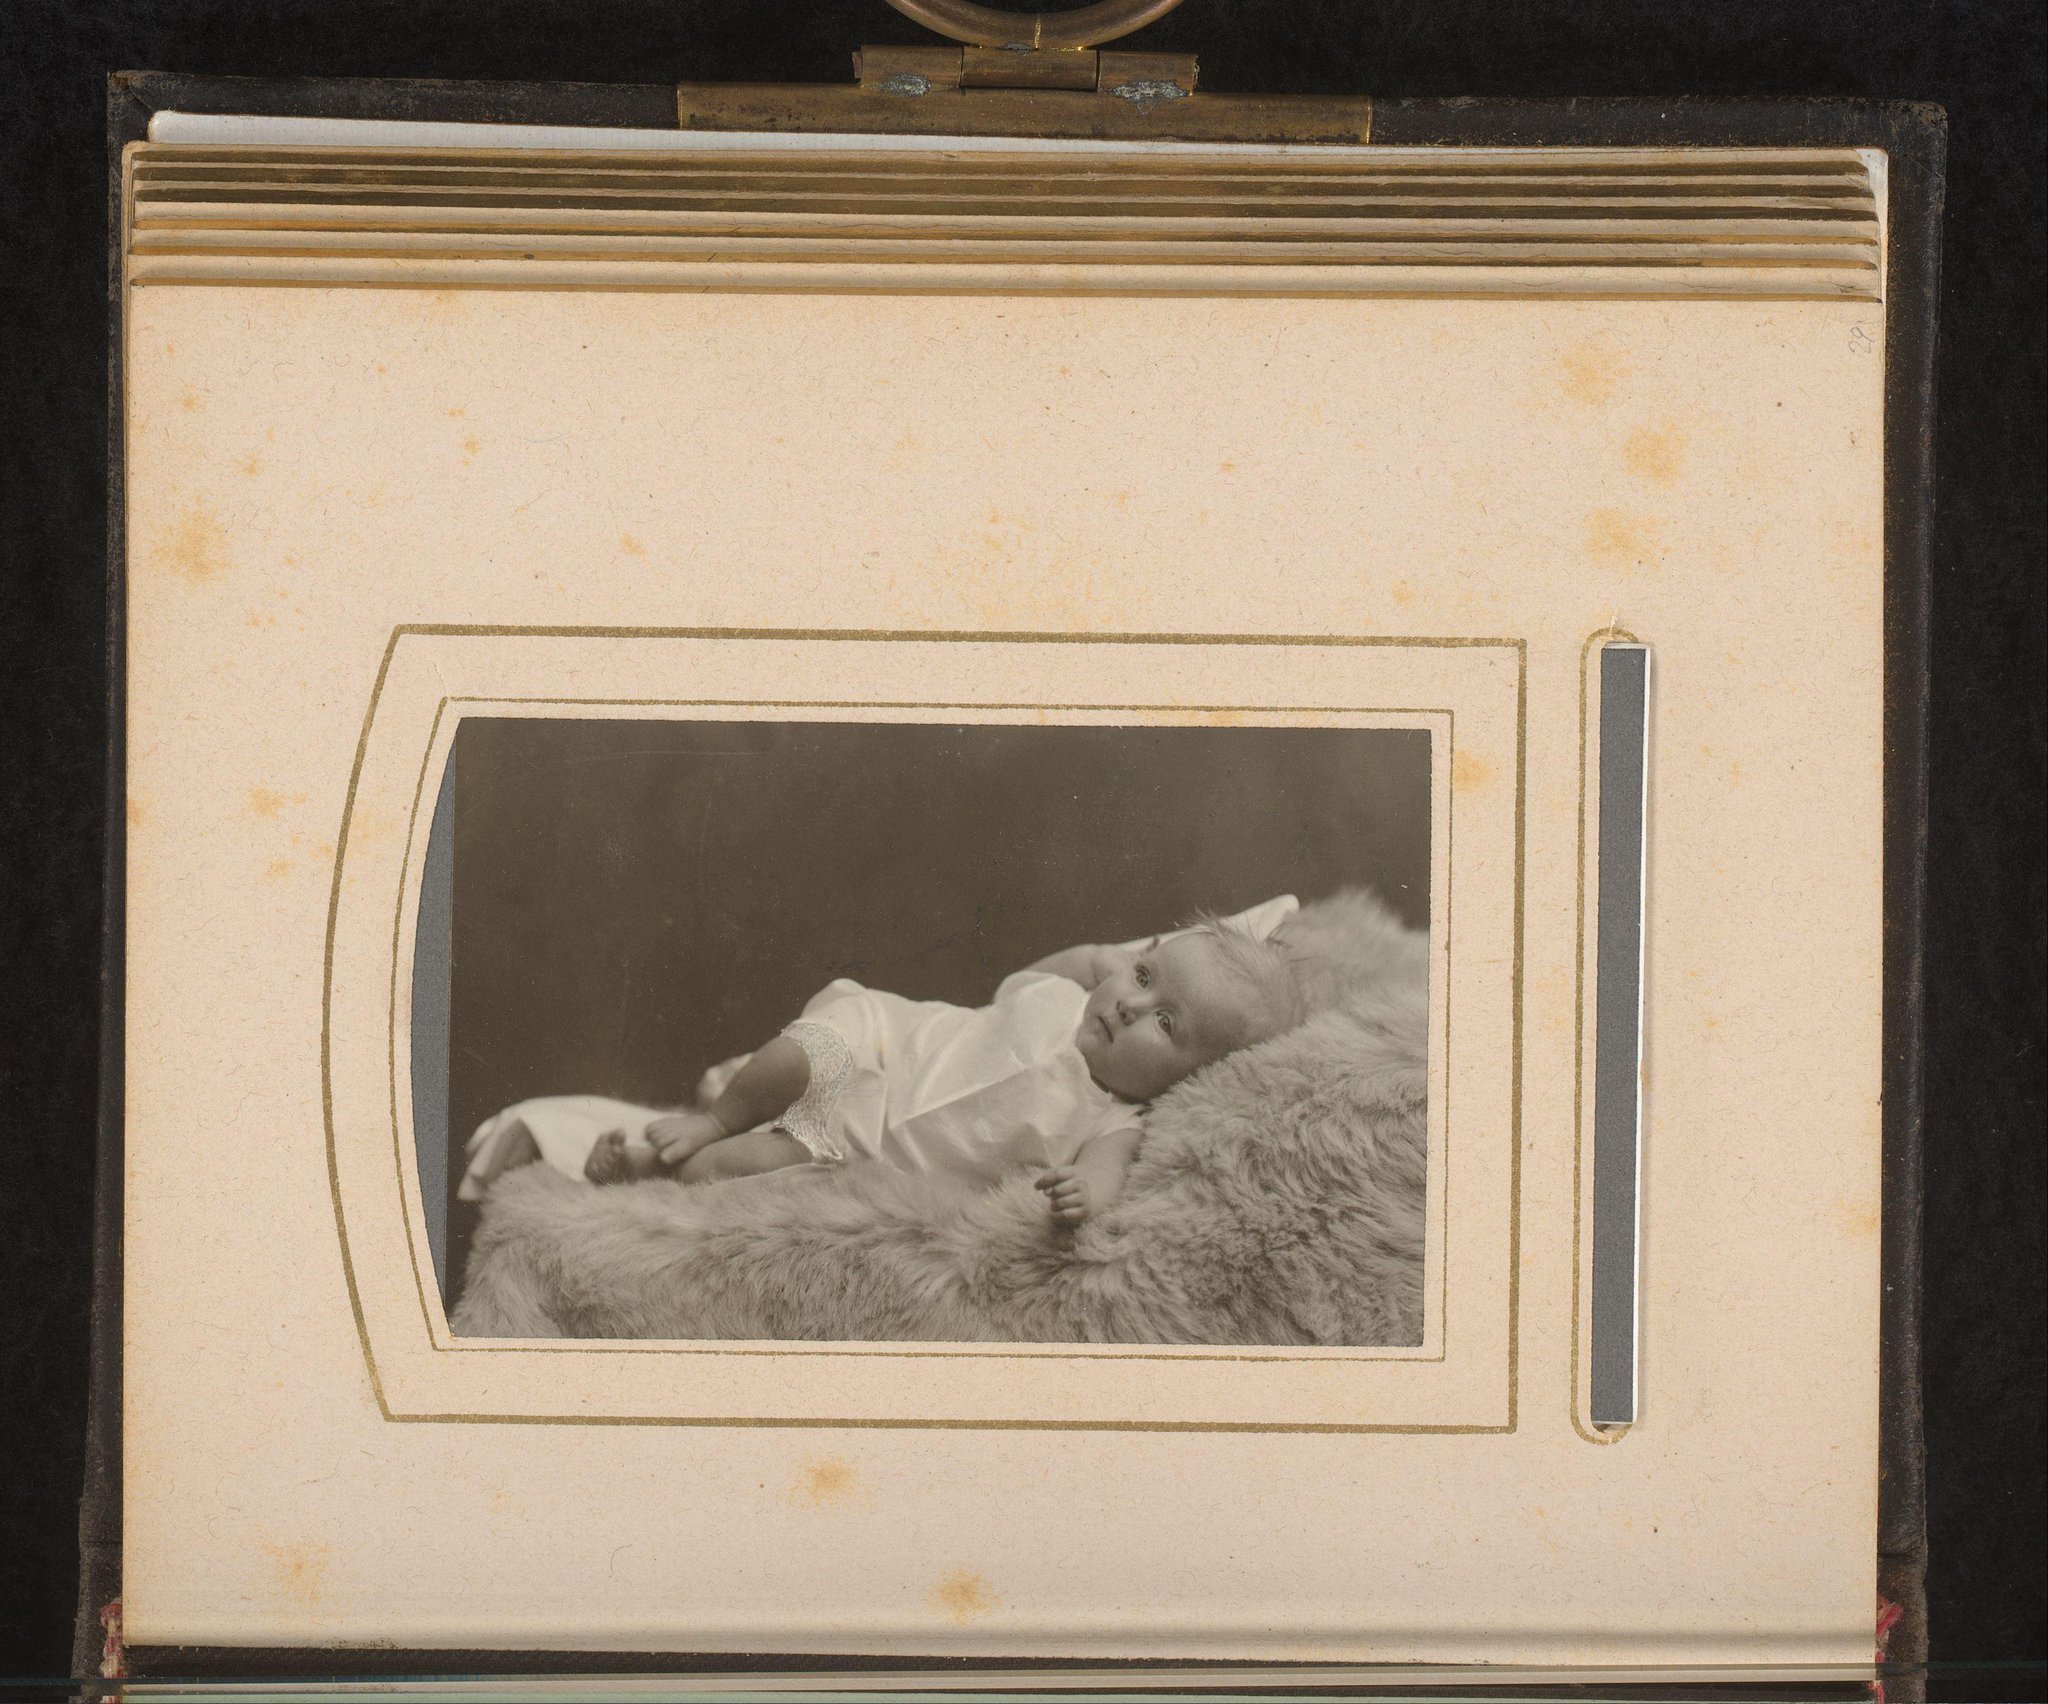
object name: carte de visite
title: Portret van een baby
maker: hans rupprecht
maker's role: fotograaf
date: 1880-1910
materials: cardboard, photographic support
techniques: collodion silver print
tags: historical persons, infant, baby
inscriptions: inscription: ‘(...)/ Hans Rupprecht/ Bremen/ Osterthorsteinweg No. 49,/ vis-à-vis der Mozartstr./ Telephon No. 1280/ (...)’